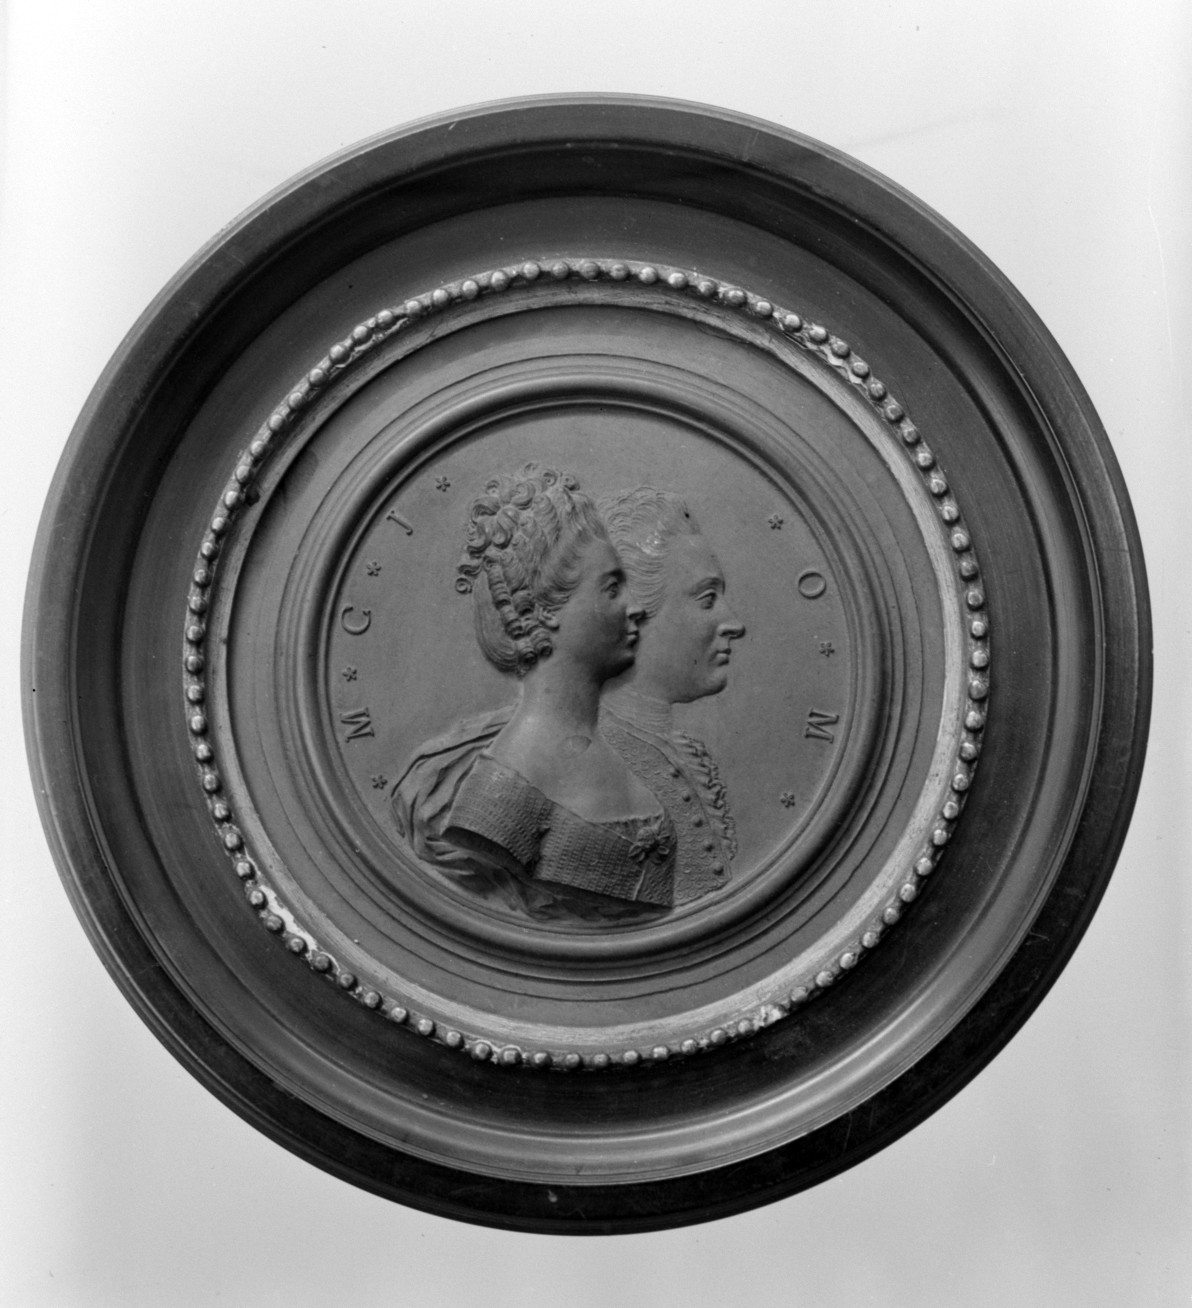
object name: medallion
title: Marie-Catherine Jacquet and her husband, Orien Marais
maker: jean-baptiste nini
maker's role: artist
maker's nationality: italian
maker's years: 1717-1786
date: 1775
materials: gilt, terracotta, wood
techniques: casting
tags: men,profiles,women